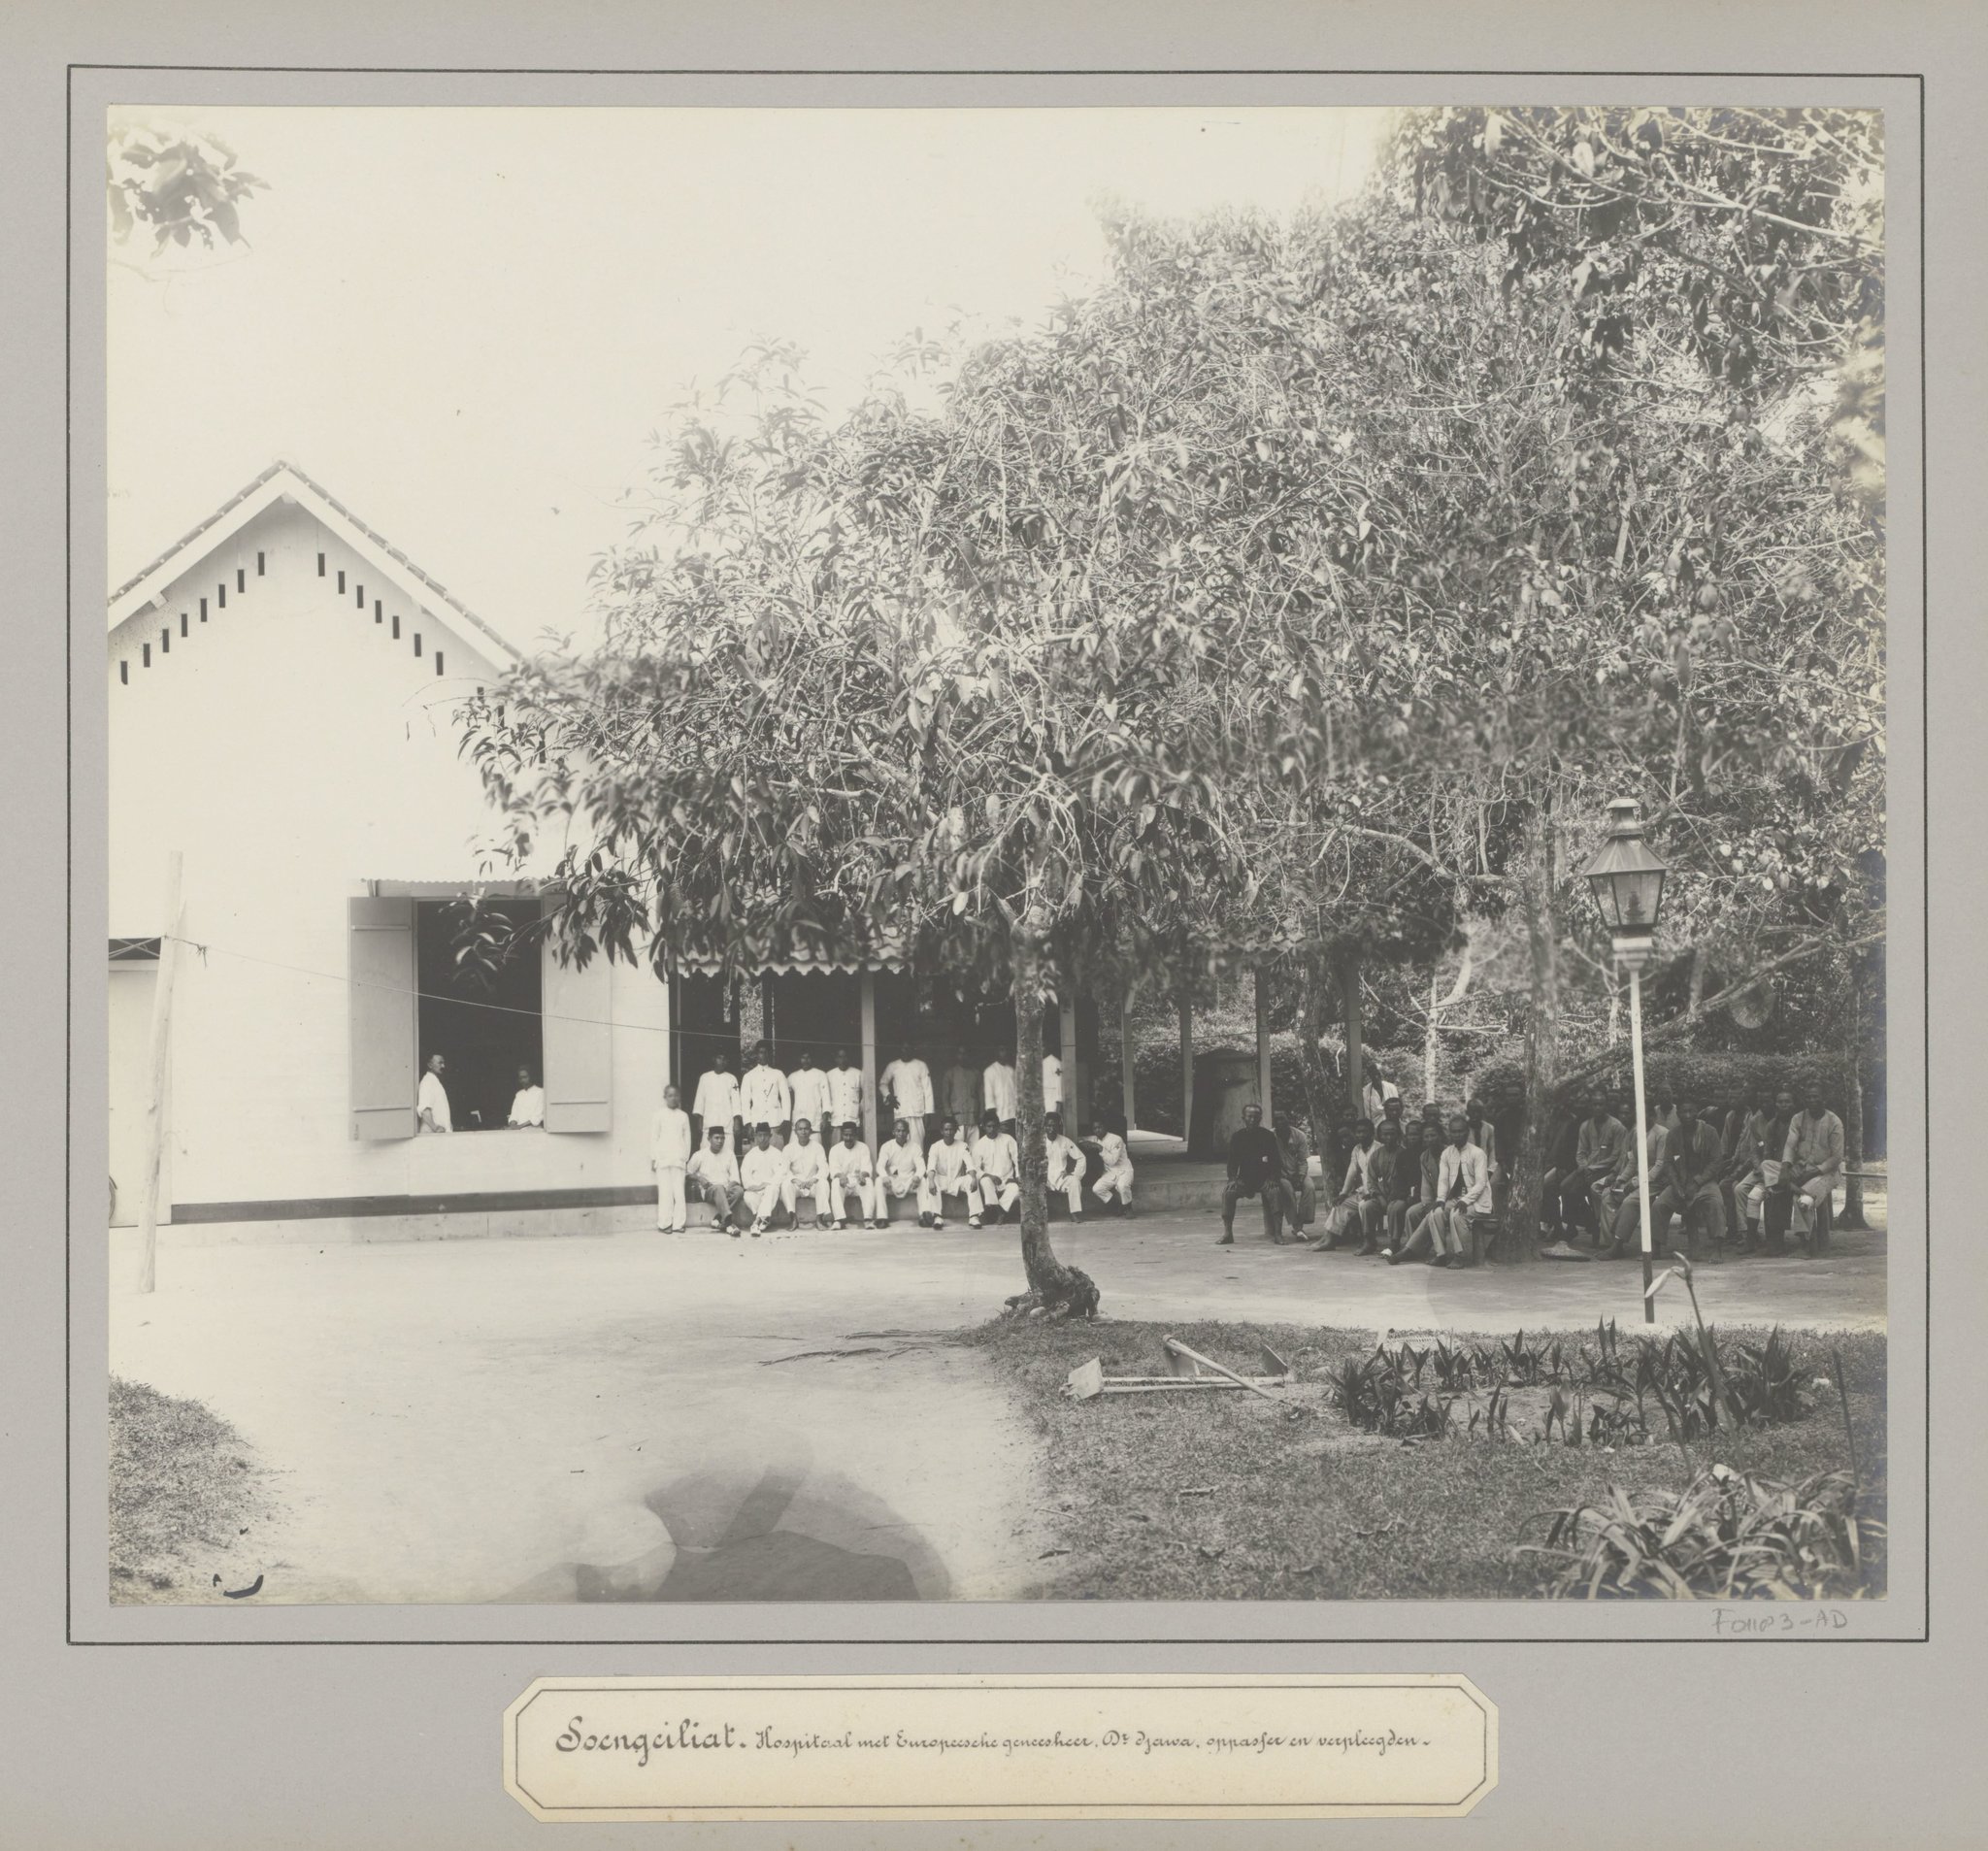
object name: photograph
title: Patiënten, Europese geneesheer dr. Djawa en assistent poserend voor een ziekenhuis te Soengeiliat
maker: Anonymous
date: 1900-1920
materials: photographic support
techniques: gelatin silver print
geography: soengeiliat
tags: mining, minerals and metals: tin, hospital, patient, sick person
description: Onderdeel van Fotoalbum over de tinwinning op Bangka.